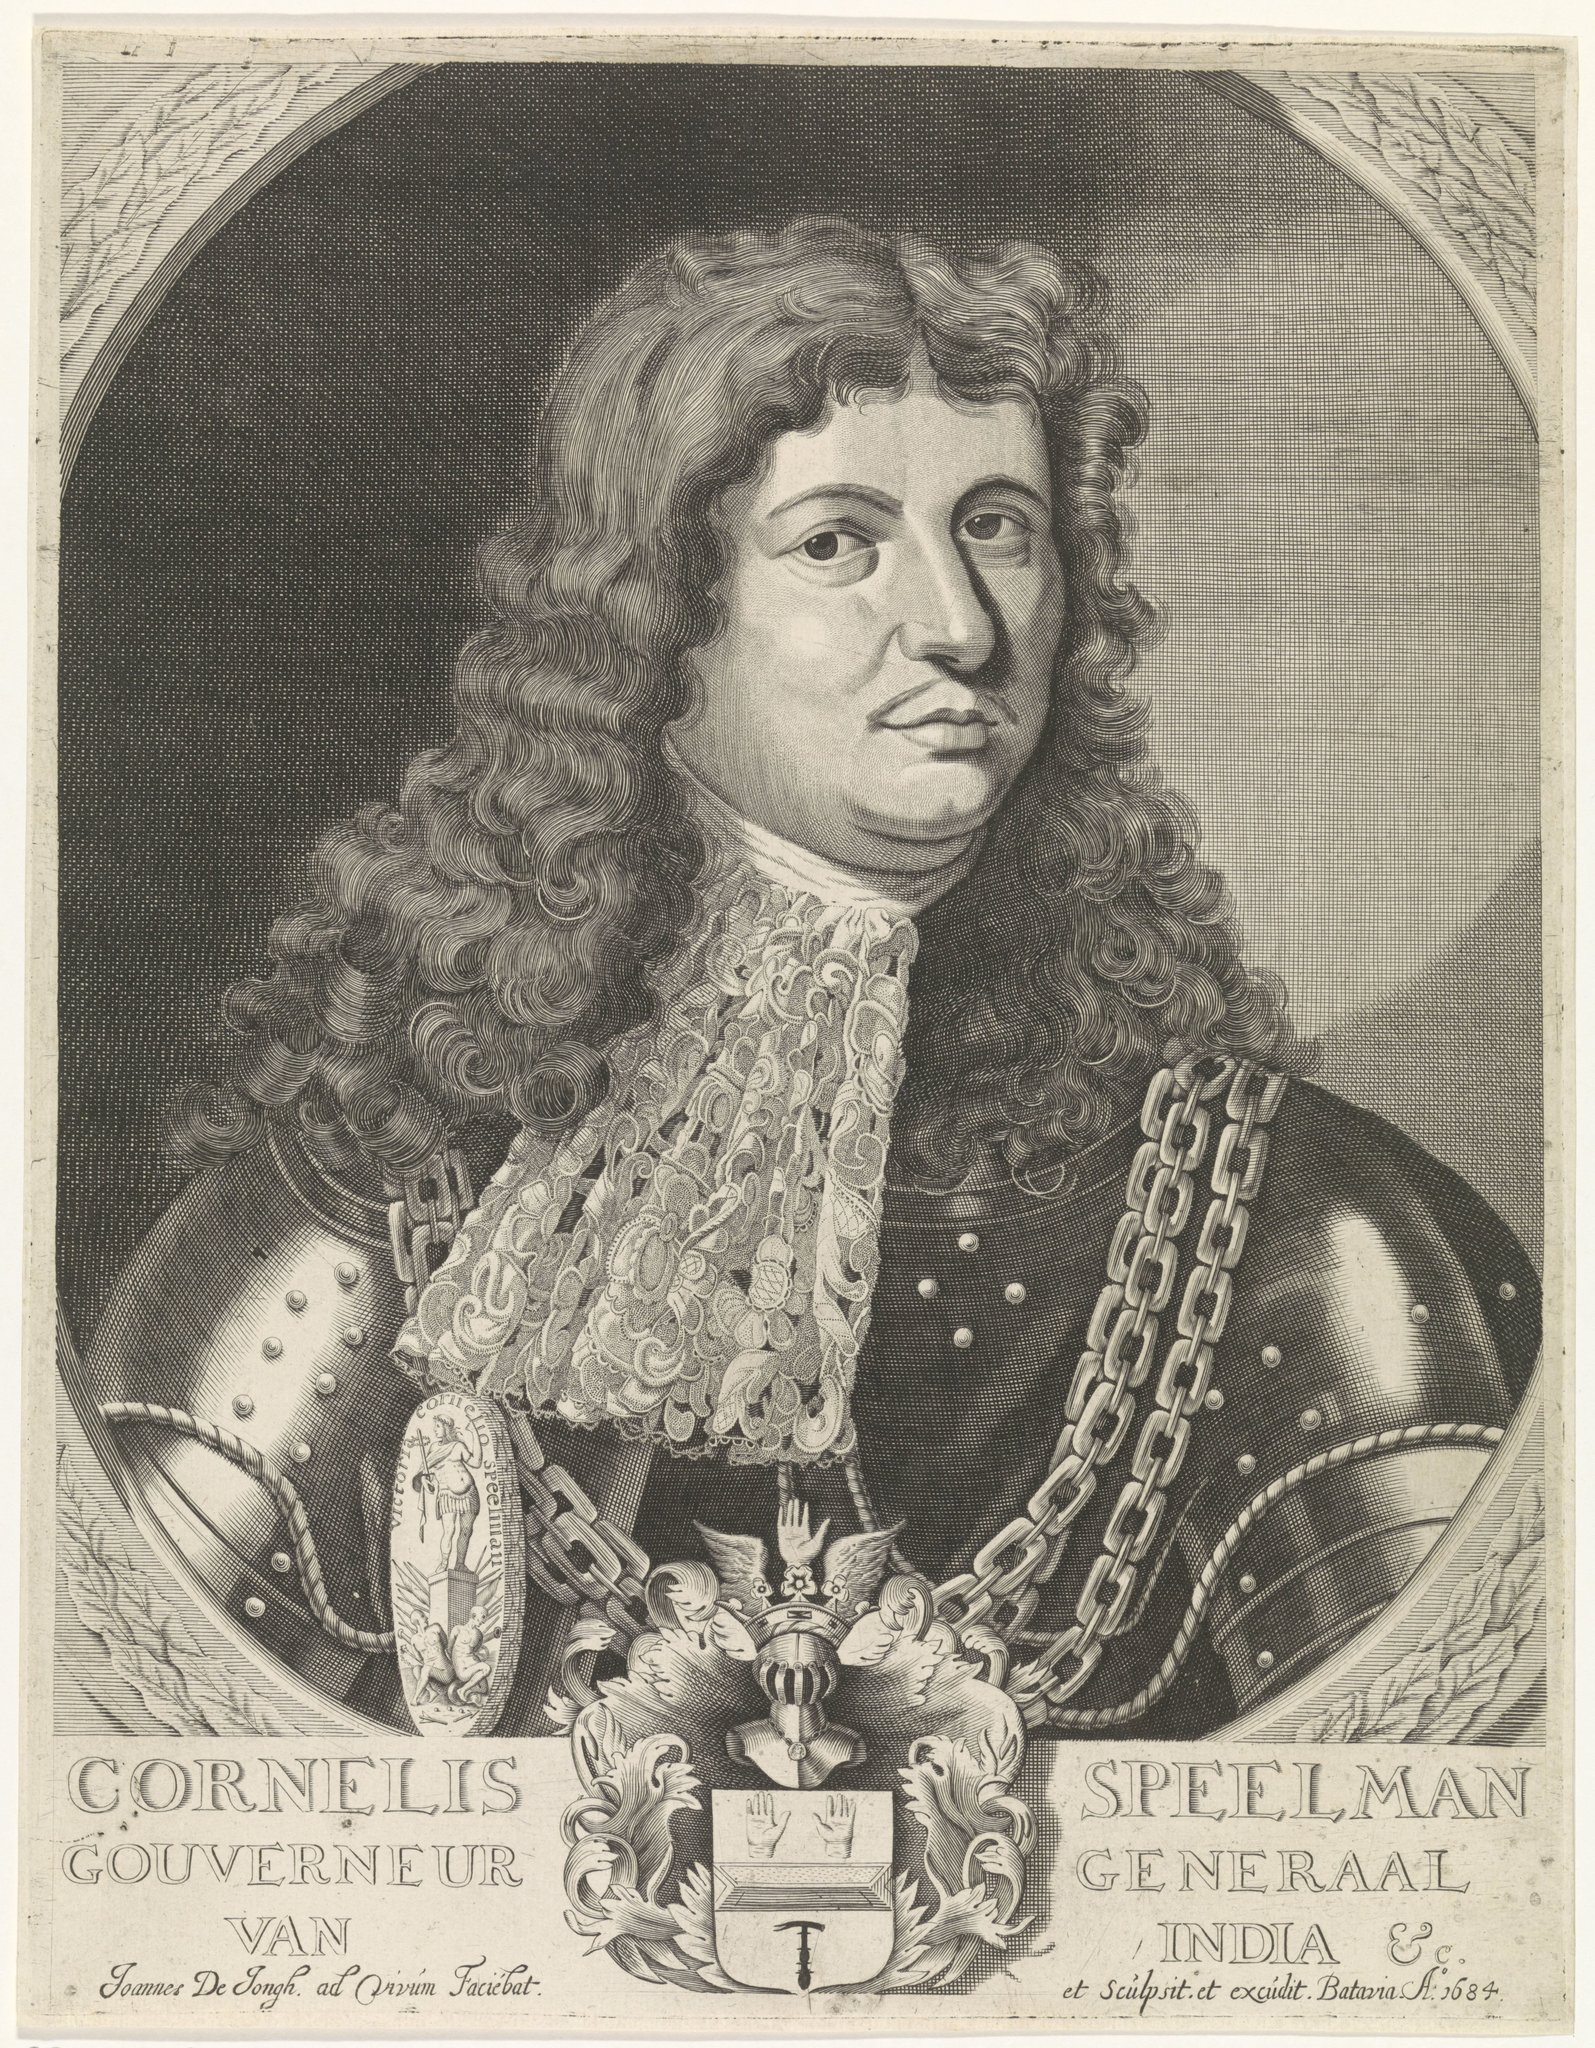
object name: print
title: Portret van Cornelis Jansz. Speelman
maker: joannes de jongh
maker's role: print maker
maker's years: 1640-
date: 1684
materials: paper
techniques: engraving, etching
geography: batavia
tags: rotterdam, batavia, armour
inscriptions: collector's mark: Lugt 2228, collector's mark: Lugt 2228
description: Busteportret van Cornelis Jansz. Speelman, gouverneur-generaal van India. Hij draagt een harnas, een geborduurde das en een ketting. Onderaan een medaillon met een standbeeld van Cornelis Speelman, twee gevangenen en een regel in het Latijn. Het portret is gevat in een gebroken ovale omlijsting met lauwerbladen in de hoeken. In de marge het wapenschild van de geportretteerde en een drieregelig onderschrift in het Nederlands.